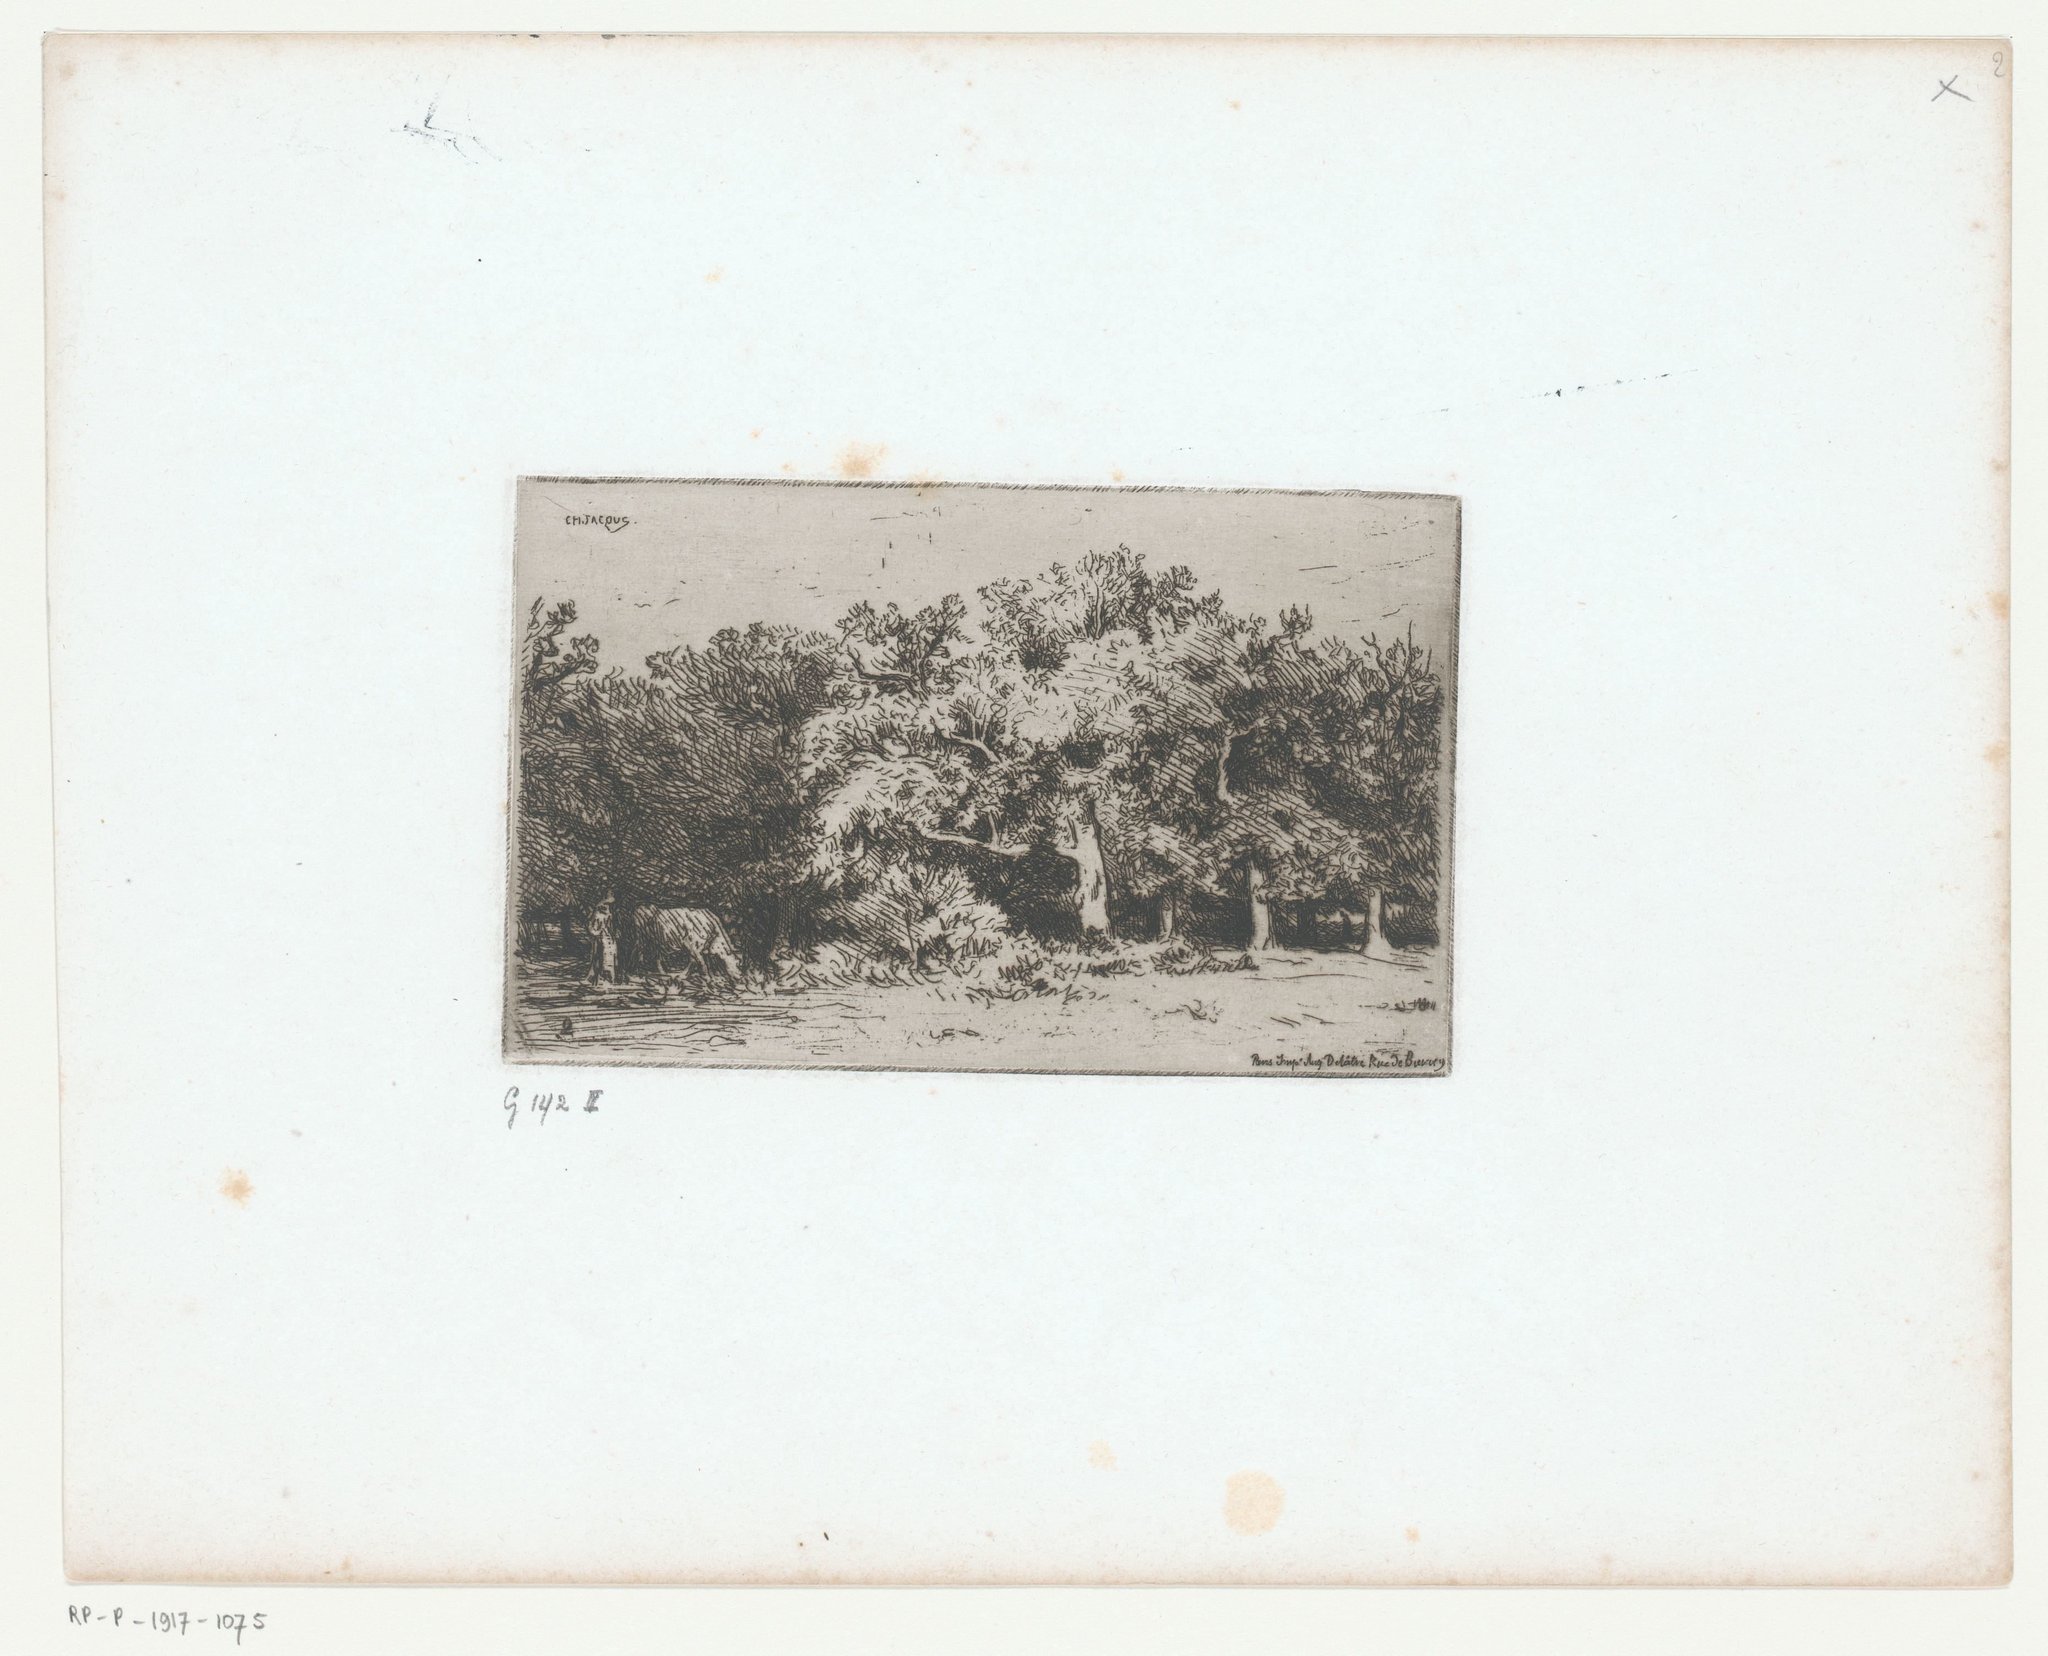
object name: print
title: Figuur met koe aan de rand van het Forêt de Fontainebleau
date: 1849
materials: paper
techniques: etching, intaglio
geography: paris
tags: fringe, edge of the wood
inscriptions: collector's mark: Lugt 2233